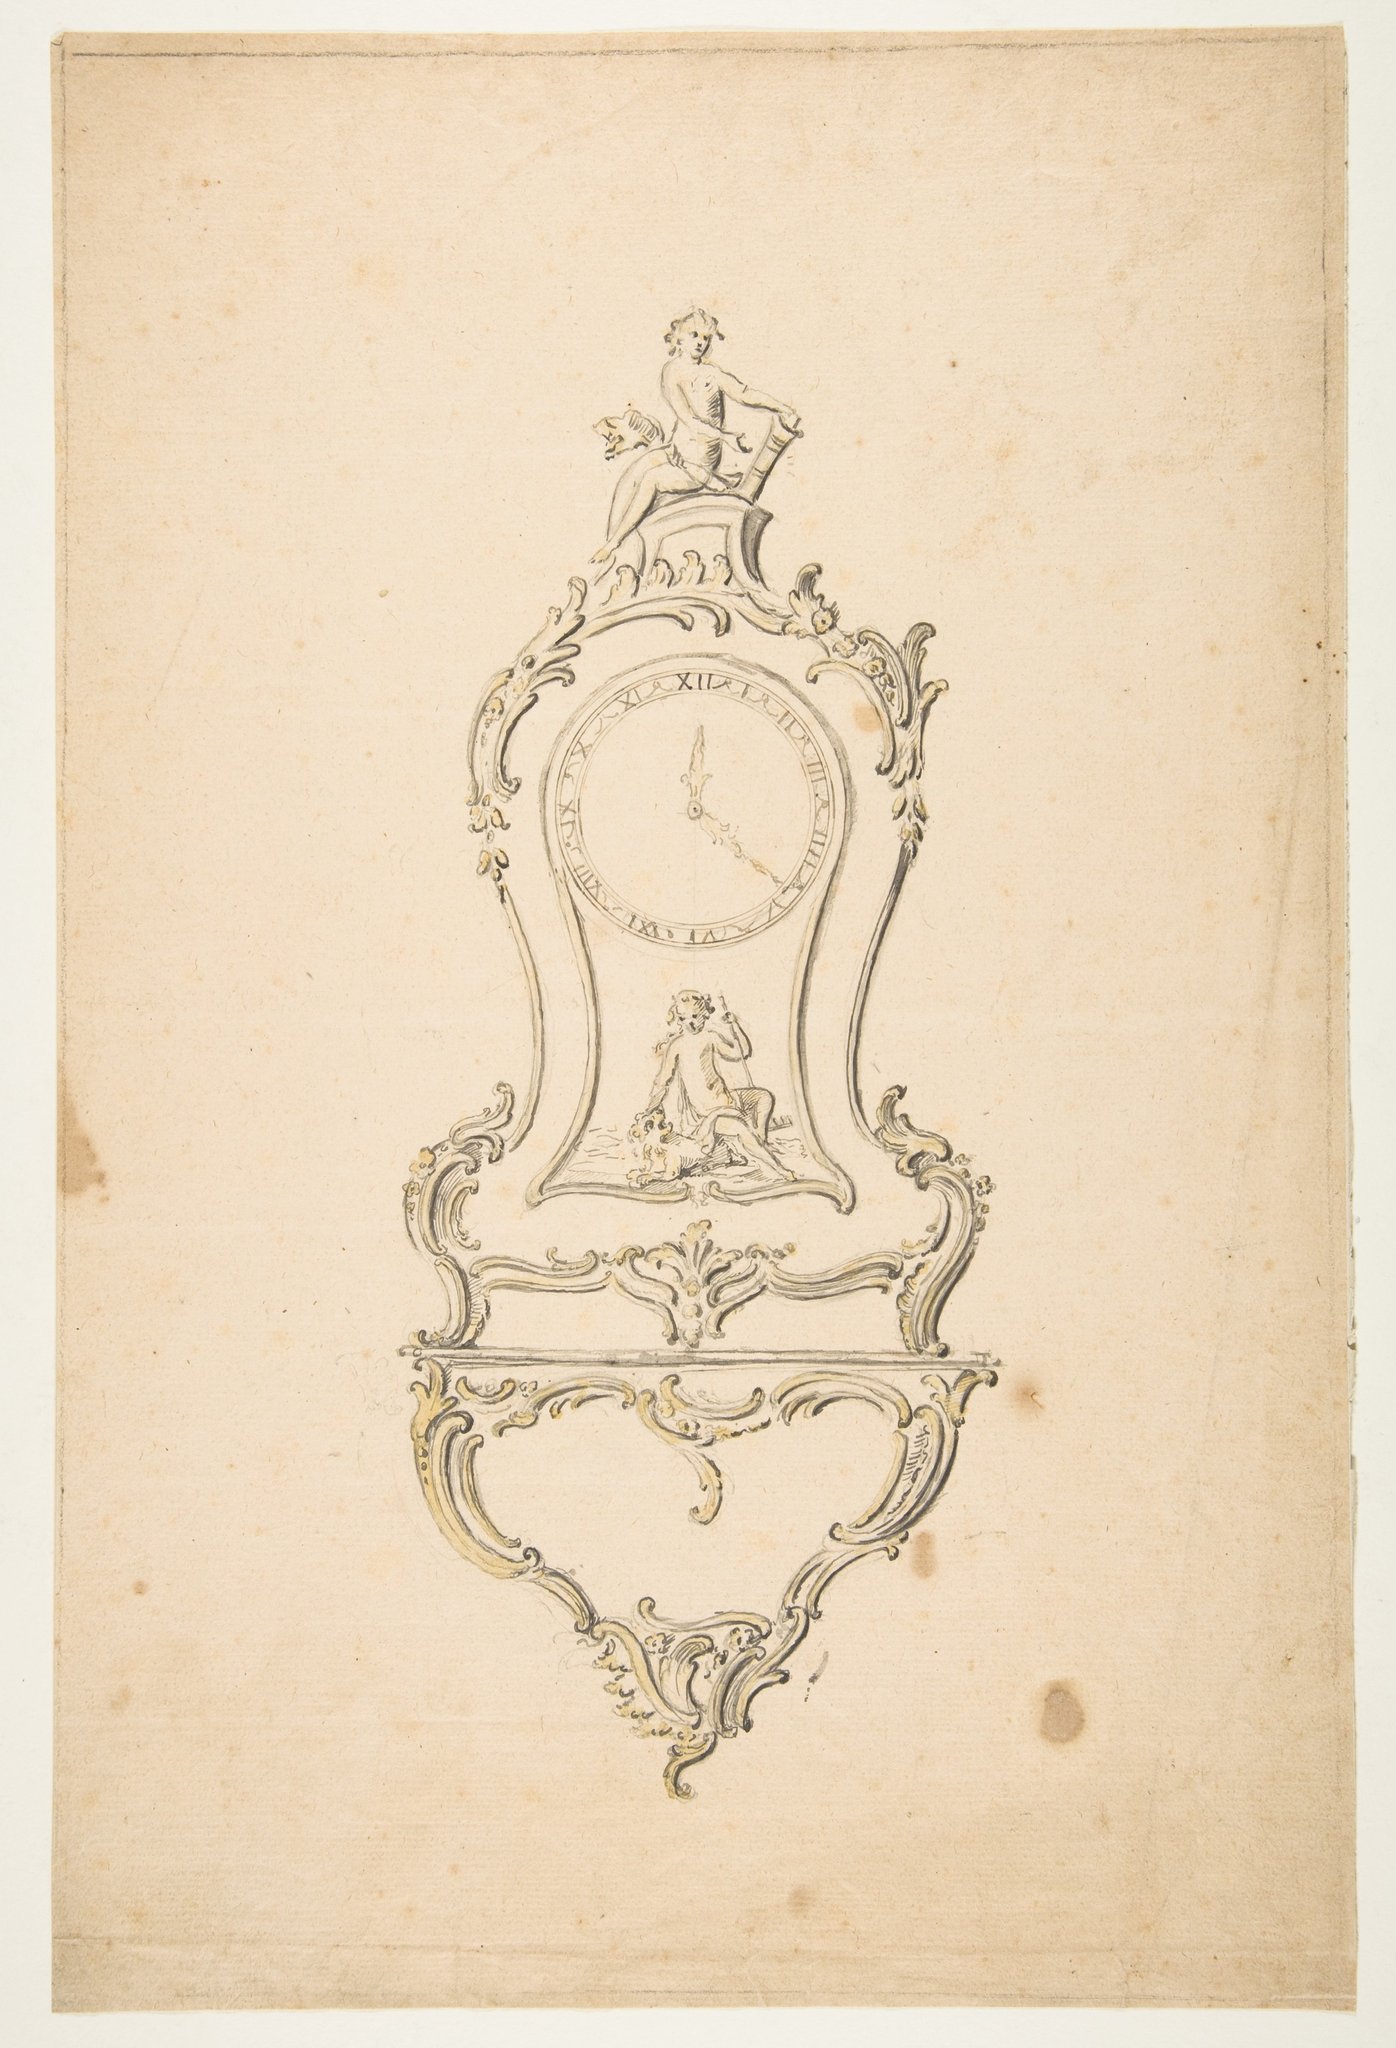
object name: drawing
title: Design for a Clock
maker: anonymous, french, 18th century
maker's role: artist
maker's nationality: french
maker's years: 1700-1800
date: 1701-1800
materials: graphite, ink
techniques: brush, pen, wash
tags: human figures,animals,clocks